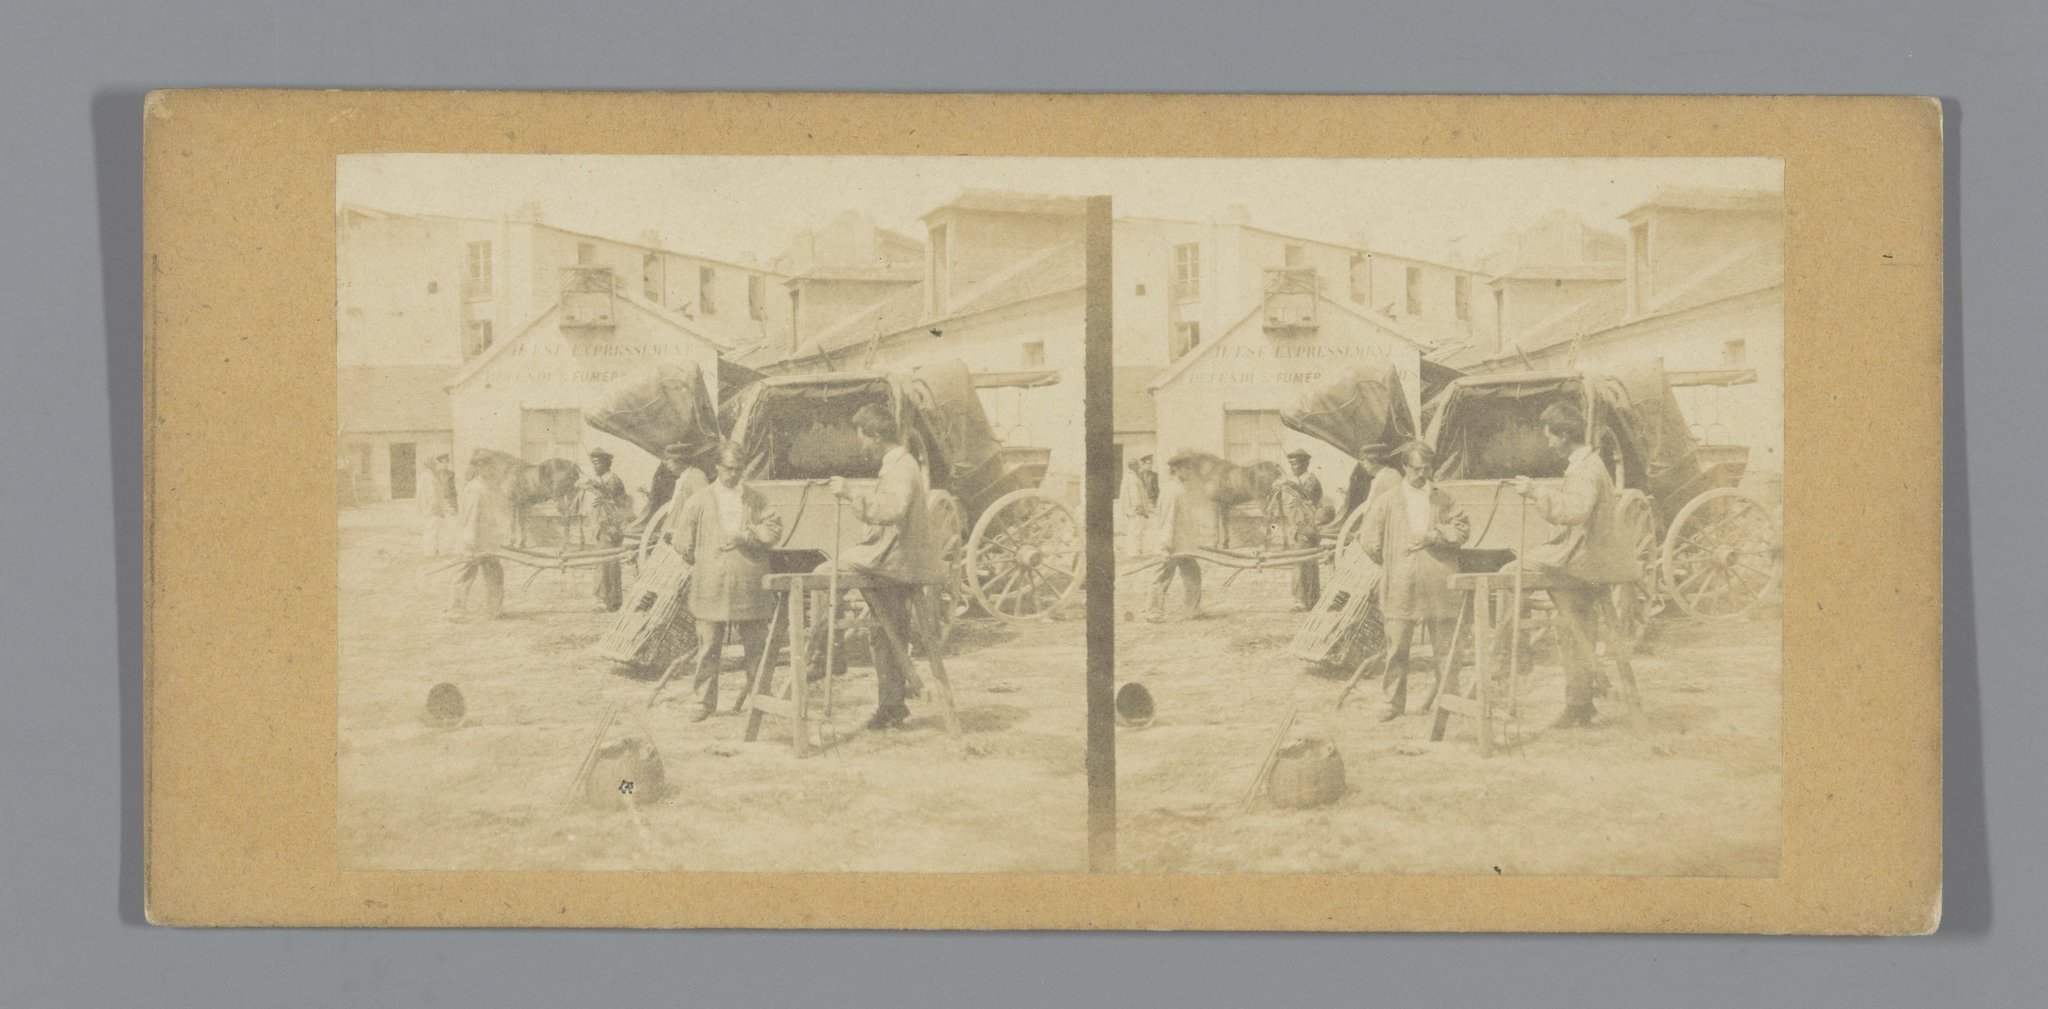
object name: stereograph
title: Mannen op een plein voor een rijtuig (vermoedelijk) te Frankrijk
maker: Anonymous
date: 1855-1860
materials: cardboard, photographic support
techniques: albumen print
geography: france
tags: adult man, passenger carriage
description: RP-F-F06465 is een ander exemplaar van dezelfde foto.